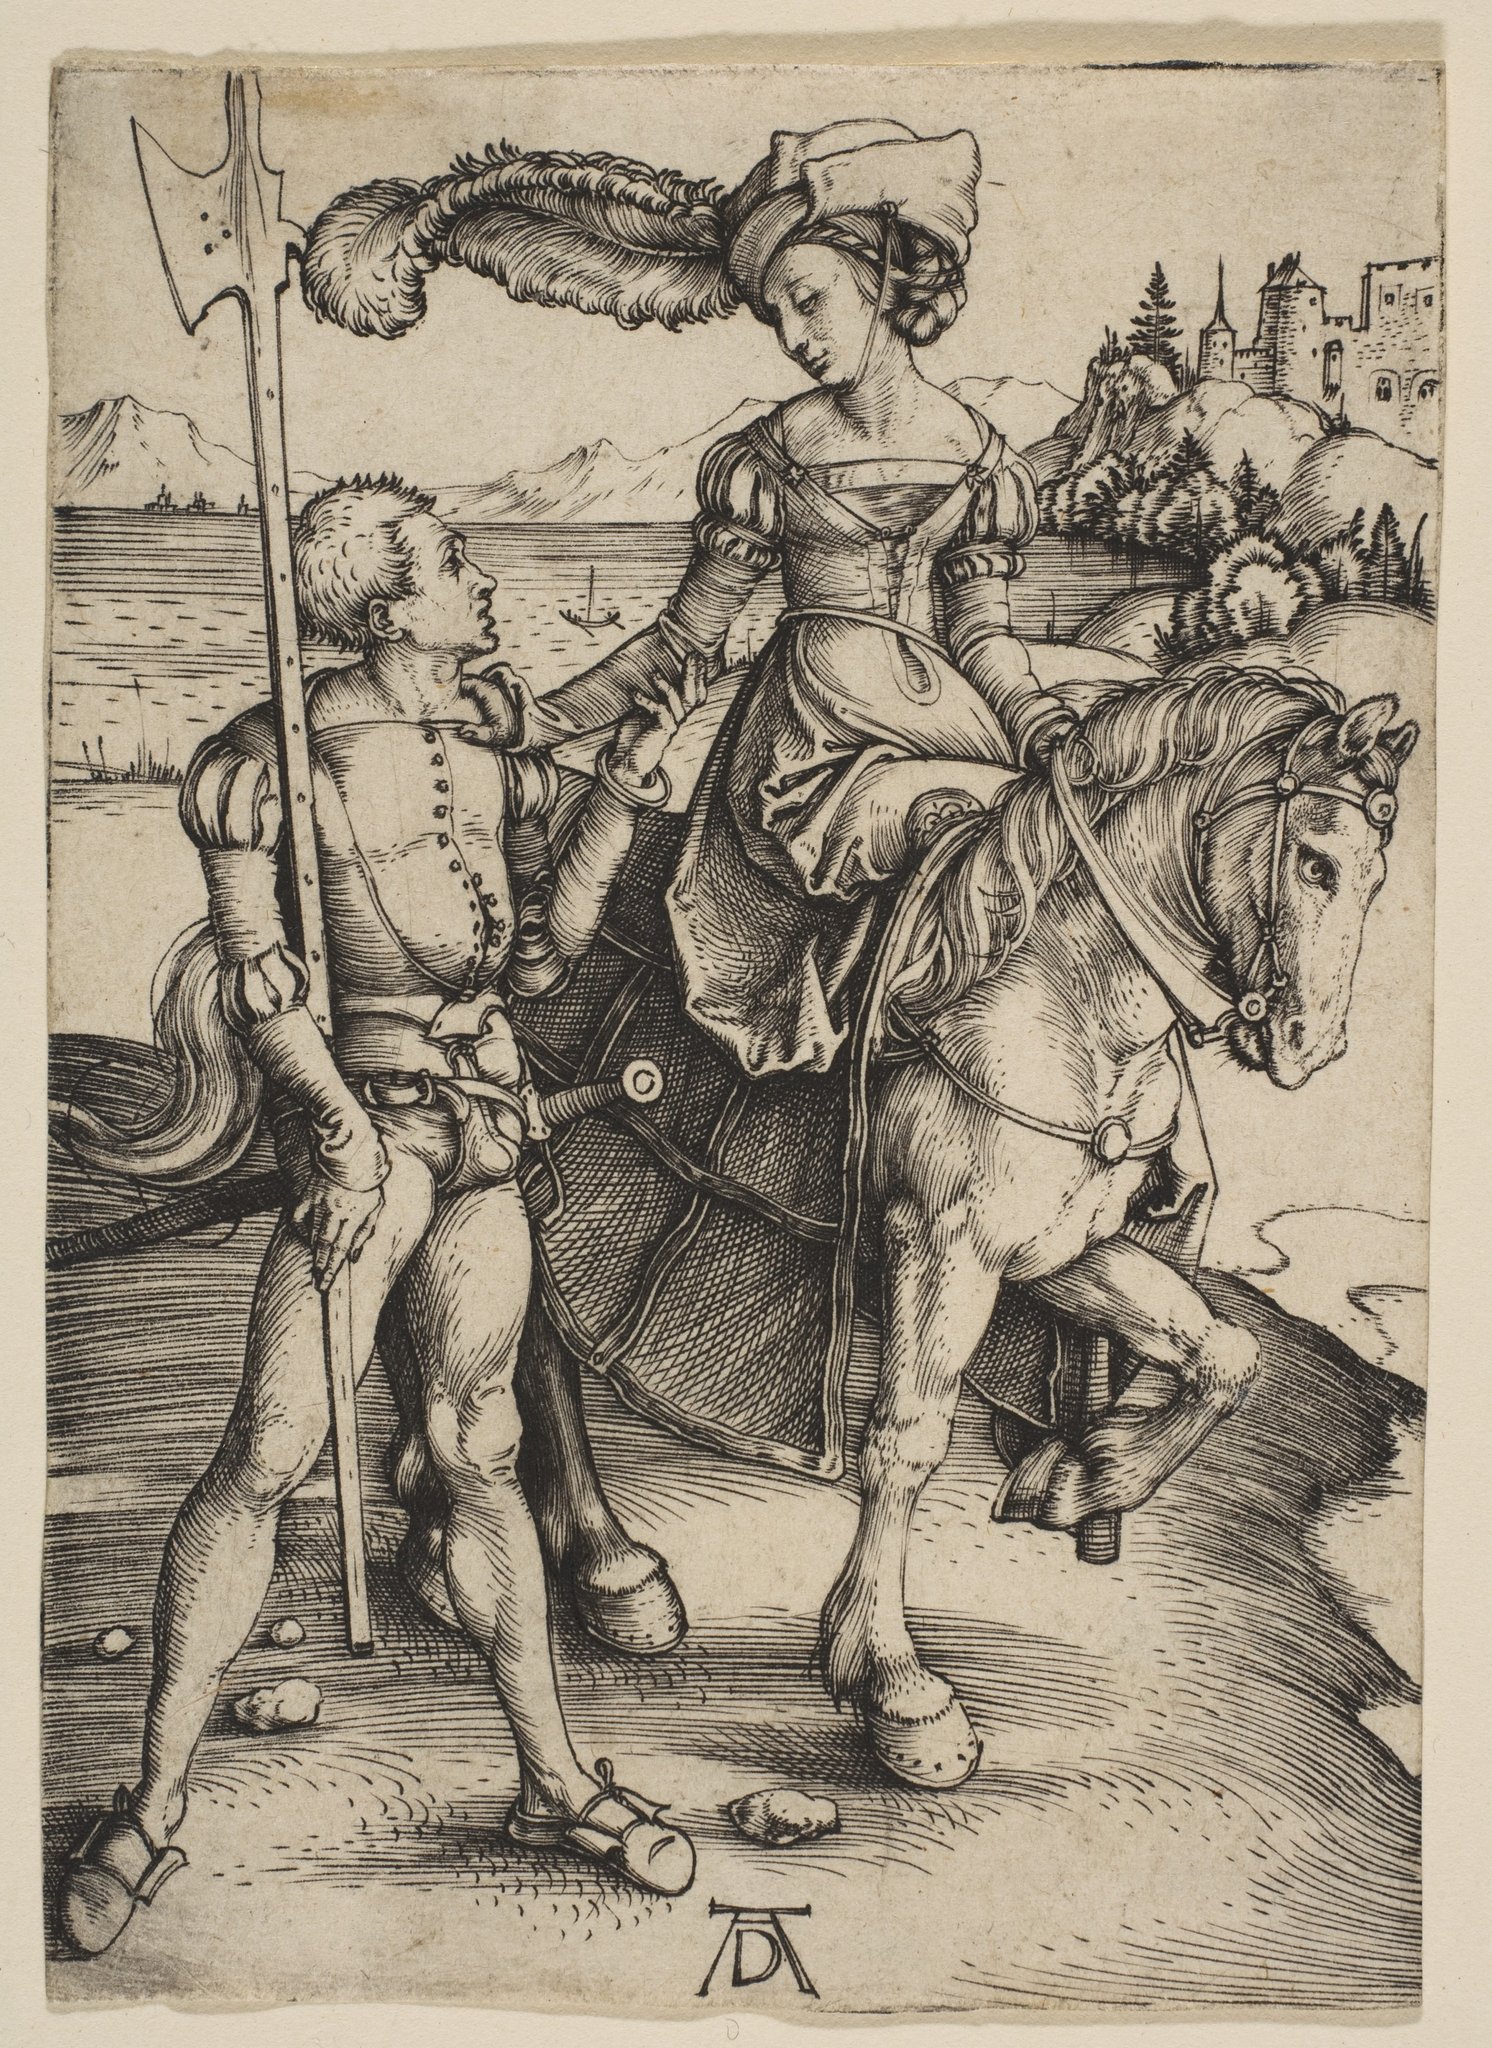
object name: print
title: The Lady on Horseback and the Lansquenet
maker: albrecht dürer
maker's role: artist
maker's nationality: german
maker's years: 1471-1528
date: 1497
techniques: engraving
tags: soldiers,men,women,horses